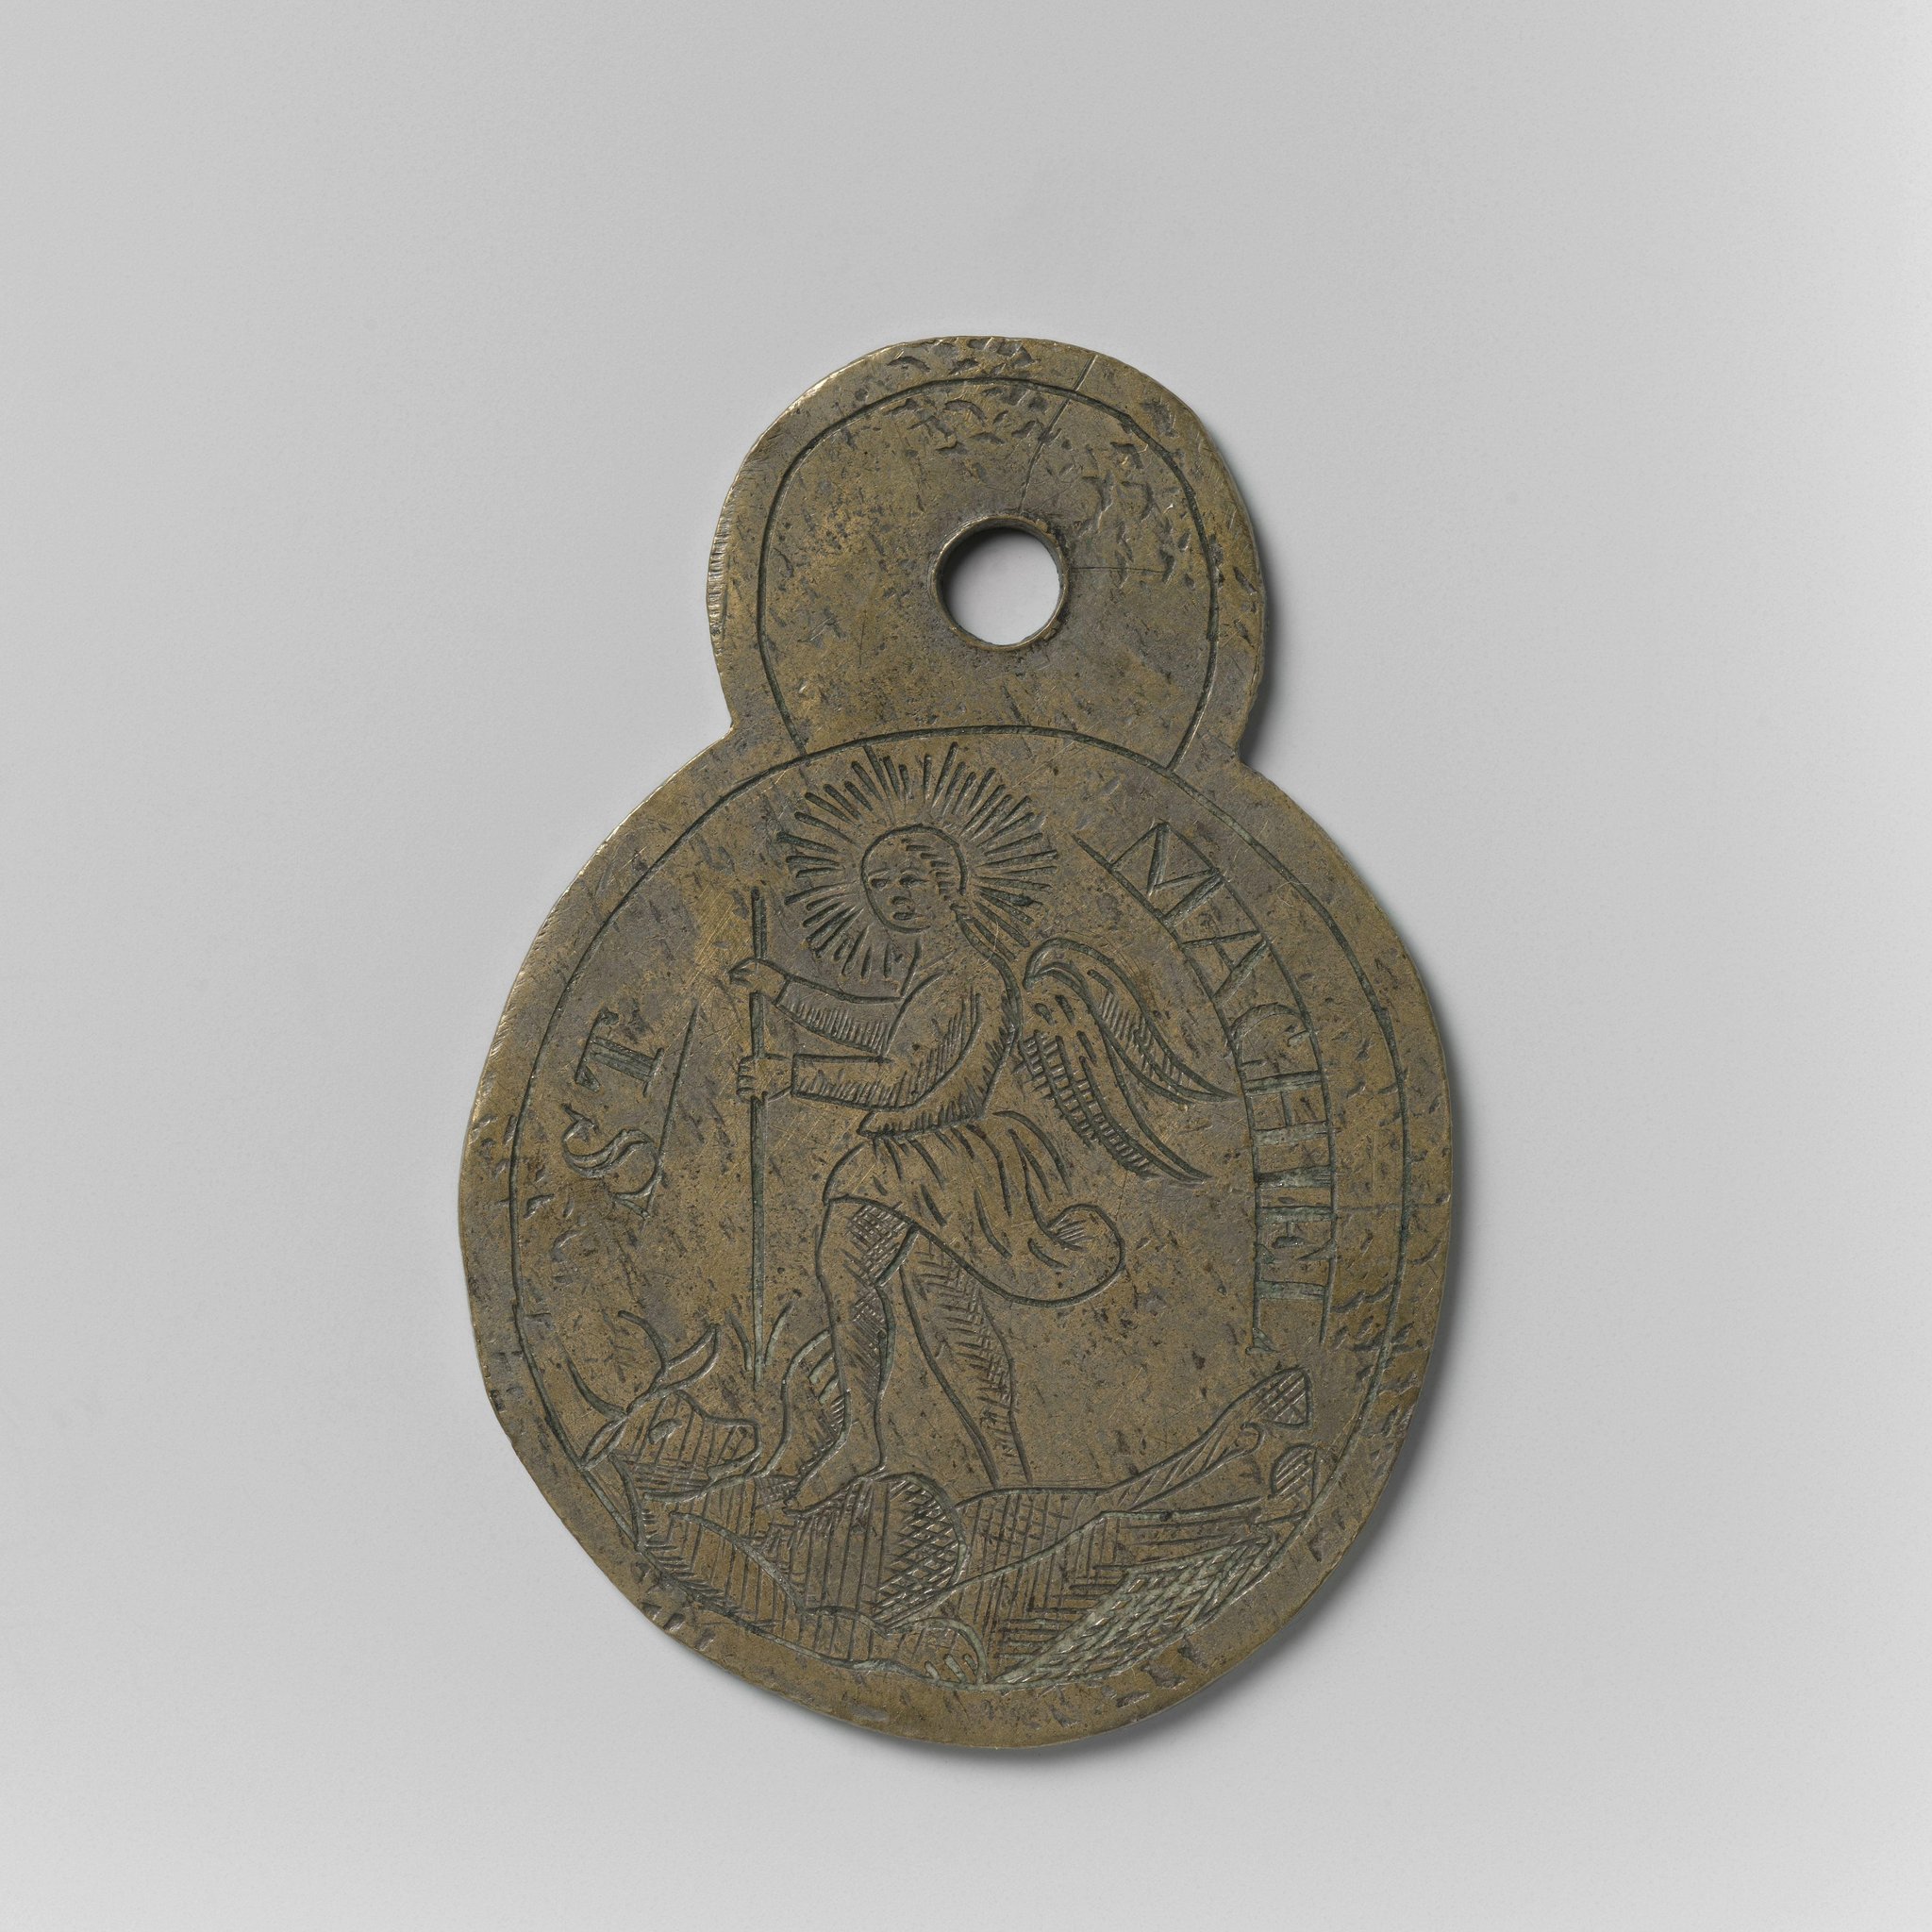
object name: medal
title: Presentiepenning van het Kleermakers- en droogscheerdersgilde te 's-Hertogenbosch 1754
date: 1754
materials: brass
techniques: engraving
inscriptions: circumscription: ‘ST - MACHIEL’, inscription: ‘1 - 7 / 5 - 4 rond N° - 32’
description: Achtvormig plaatje messing gegraveerd op de voorzijde Sint Michiel die een gehoornd monster verslaat, op de keerzijde een schaar tussen de cijfers van het jaartal 1754 en het nummer 32, met draaggat